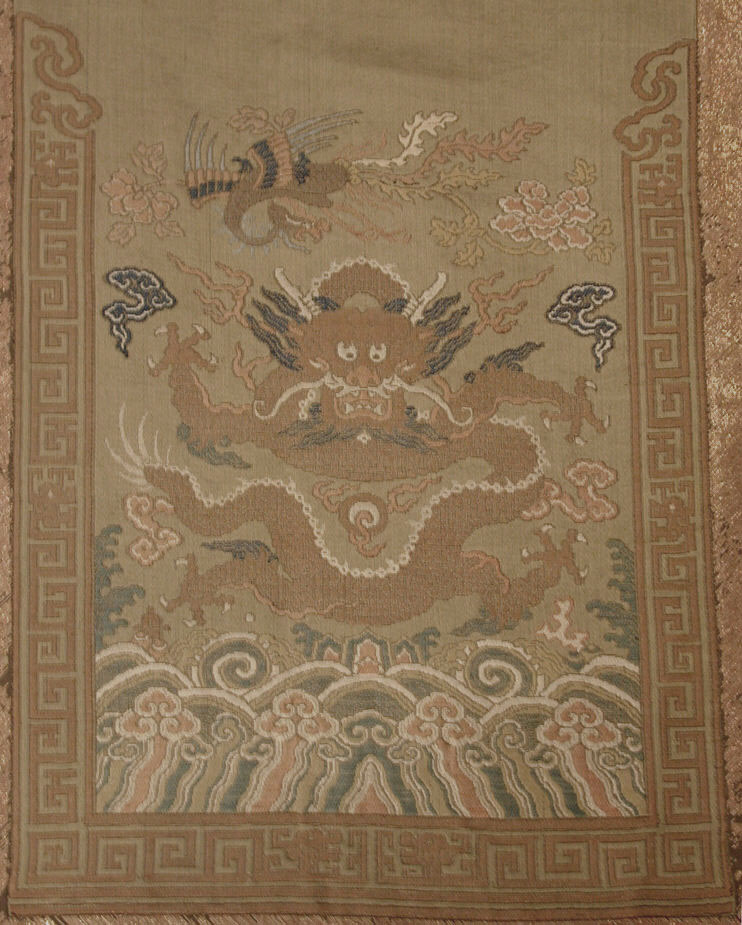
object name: piece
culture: chinese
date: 1644-1911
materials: silk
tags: dragons,phoenix